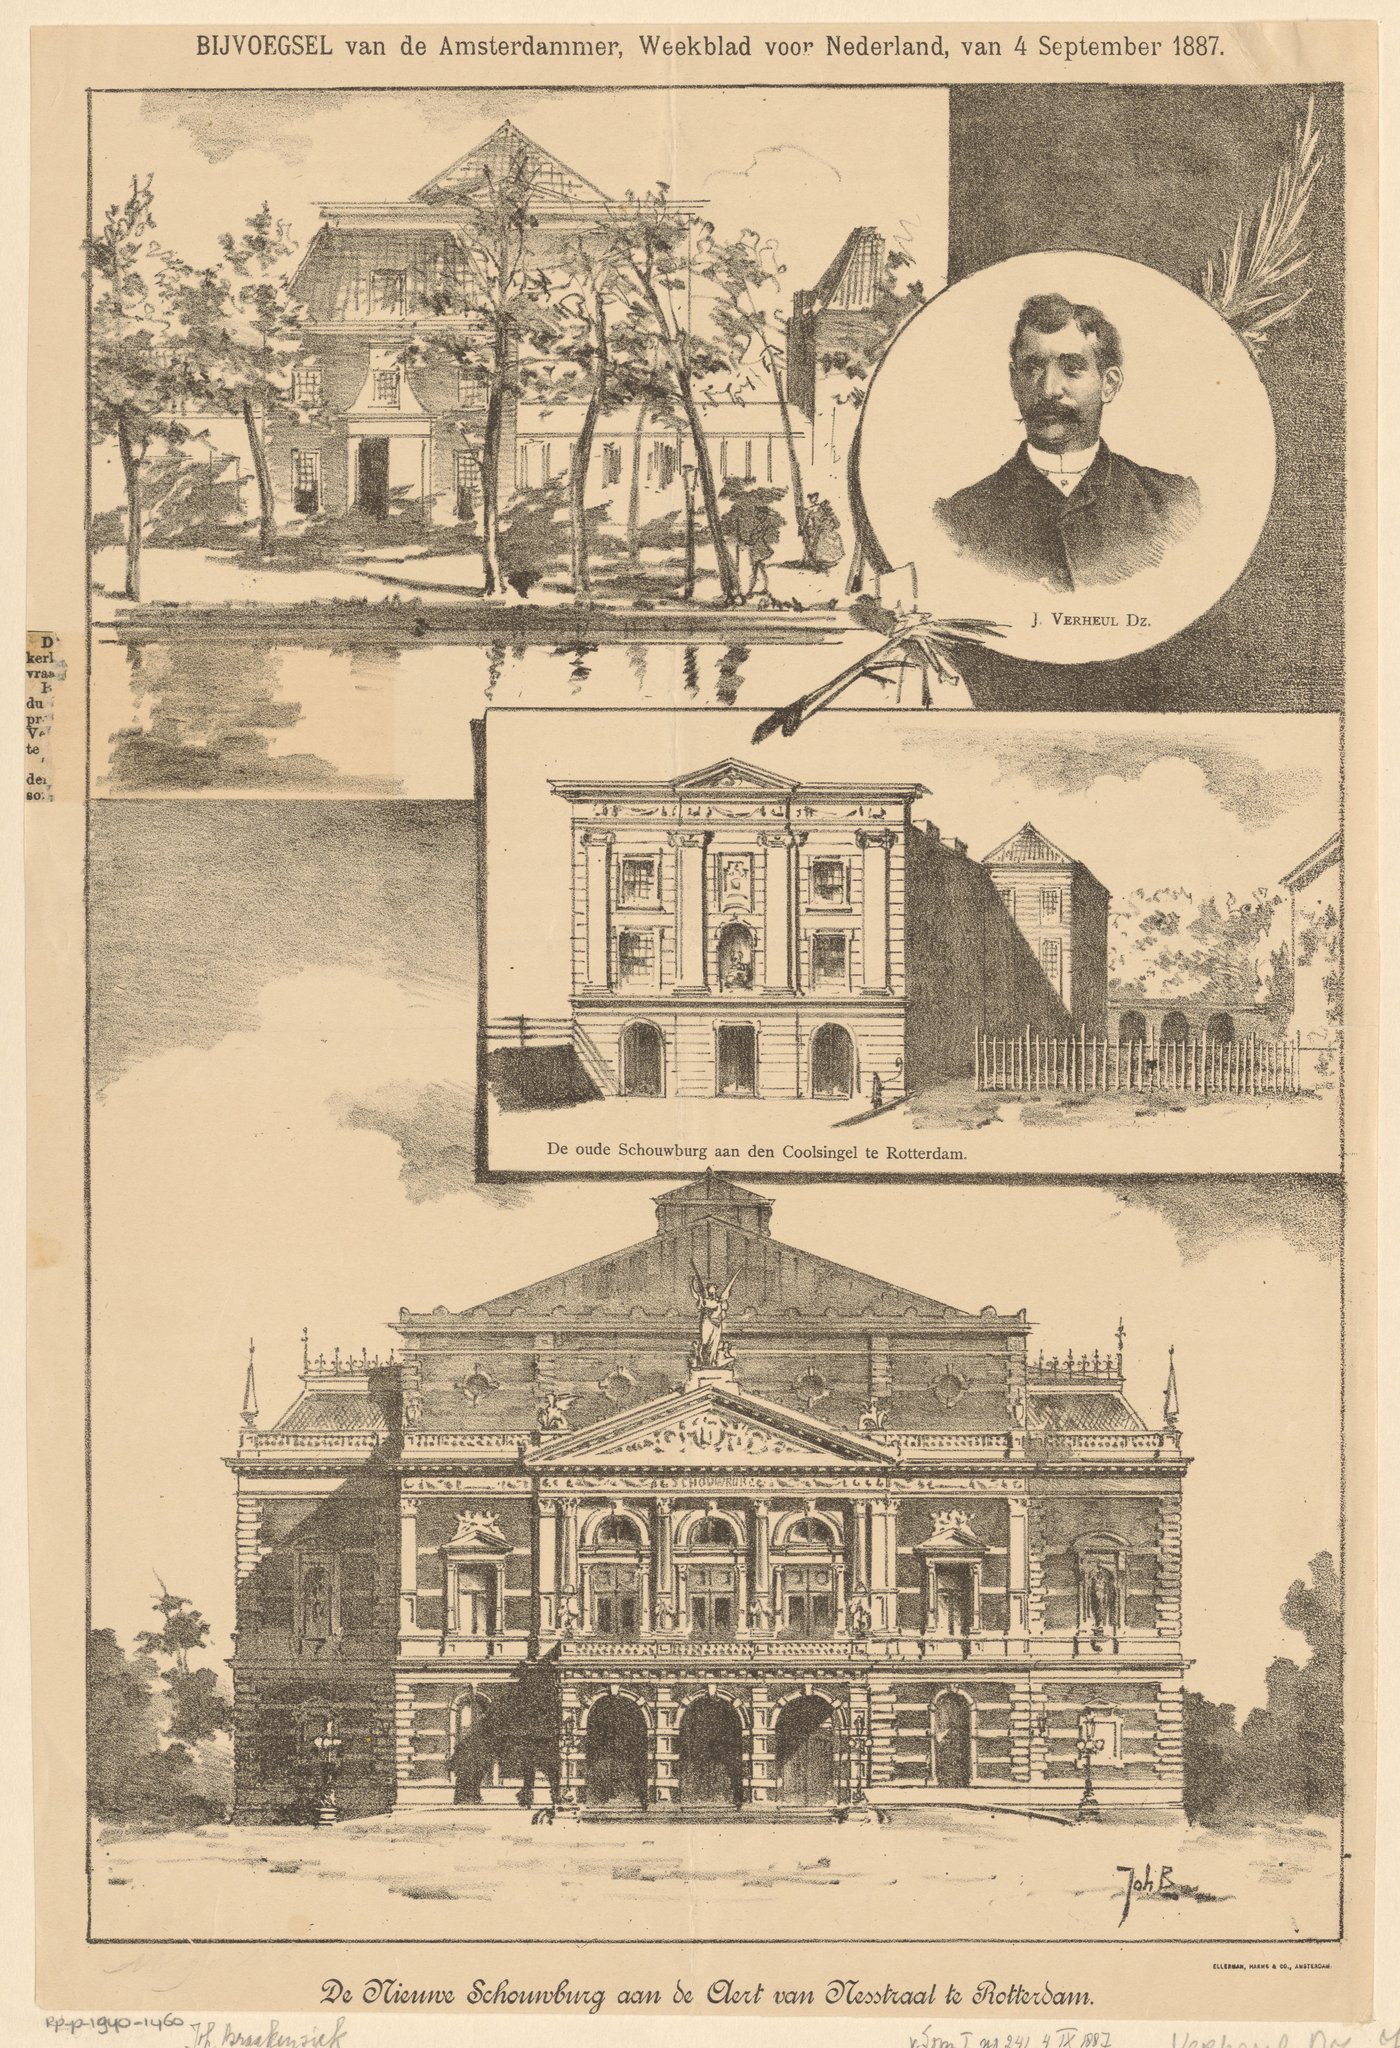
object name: print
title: Portret van J. Verheul met de nieuwe Schouwburg aan de Aert van Nesstraat en de oude Schouwburg aan den Coolsingel te Rotterdam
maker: johan braakensiek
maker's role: draughtsman, print maker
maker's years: 1858-1940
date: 1887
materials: paper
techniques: lithograph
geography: amsterdam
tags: rotterdam, draughtsman, designer, historical persons, portrait, self-portrait of architect, theatre (building)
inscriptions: collector's mark: Lugt 2760, collector's mark: Lugt 2228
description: Prent uit het bijvoegsel van: De Amsterdammer. Weekblad voor Nederland, 4 september 1887.